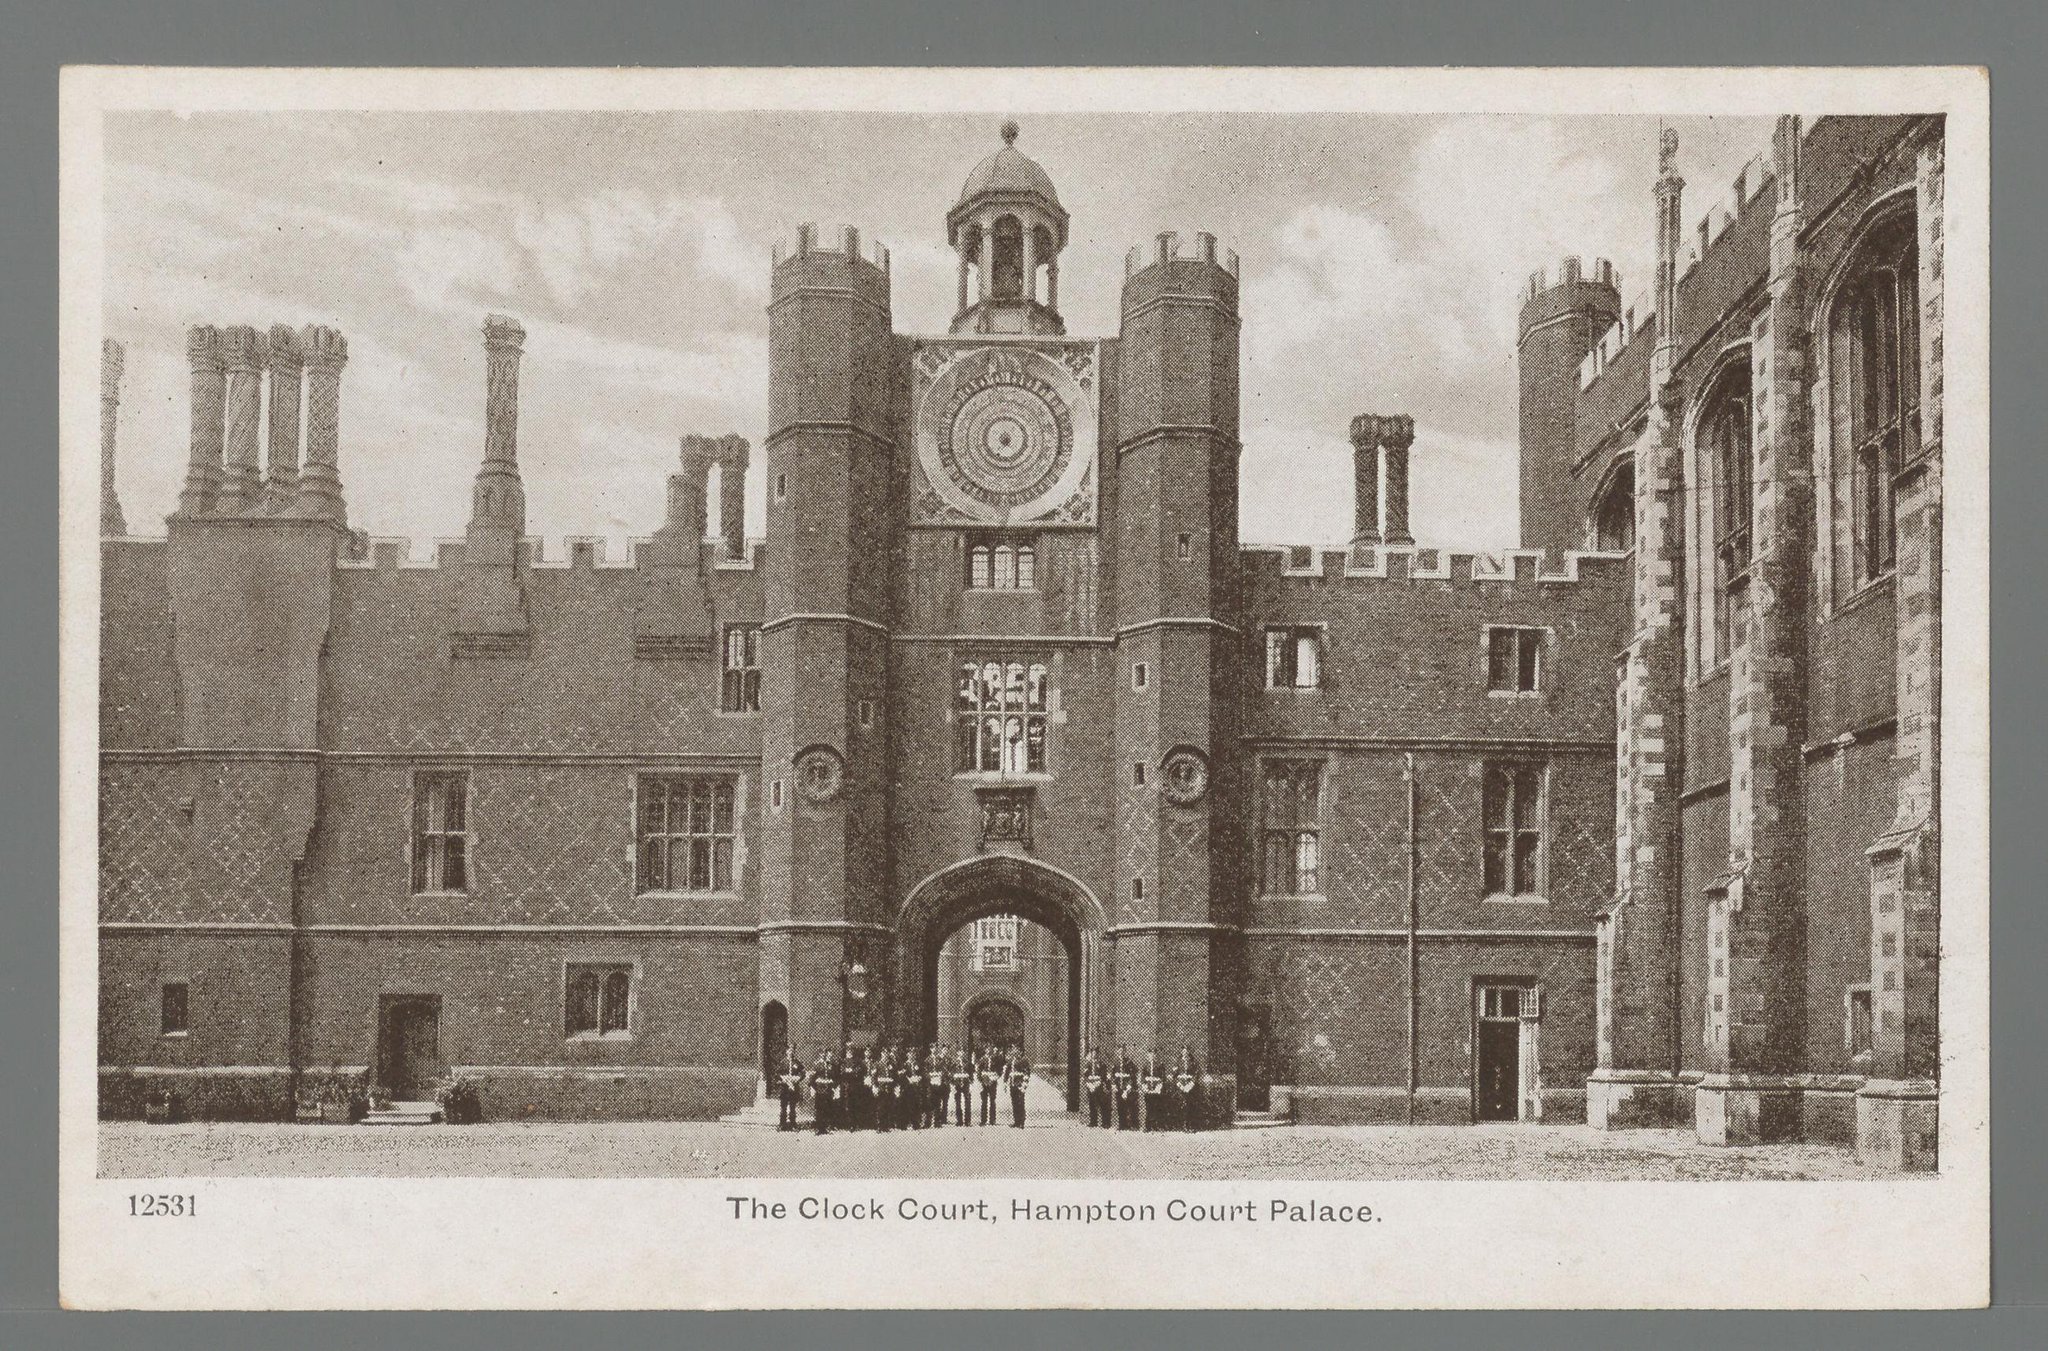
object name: ansichtkaart, prentbriefkaart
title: The Clock Court, Hampton Court Palace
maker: Anonymous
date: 1915-1930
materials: cardboard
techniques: autotype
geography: london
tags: palace